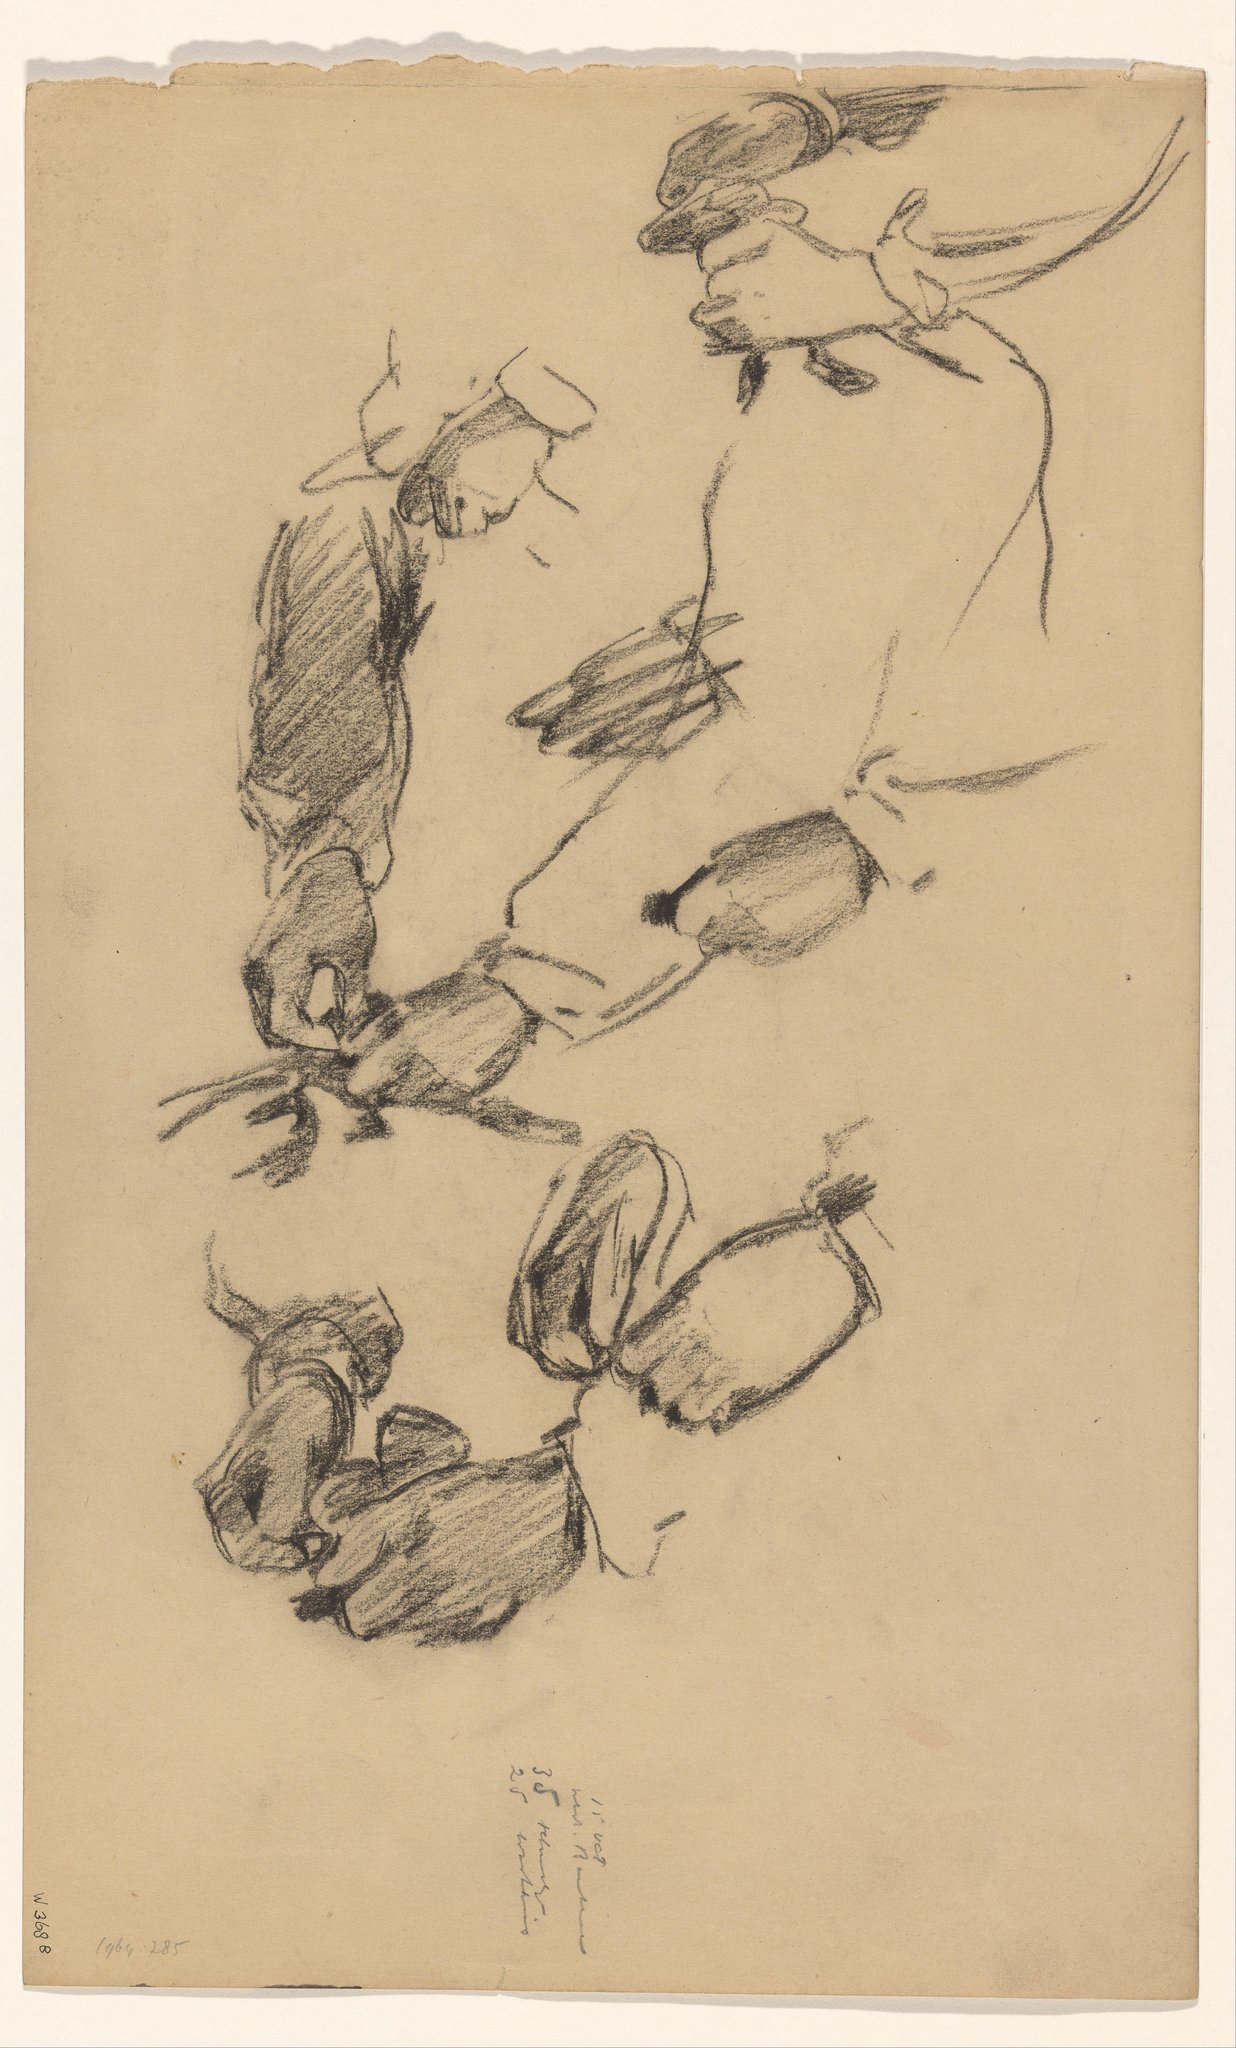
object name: sketchbook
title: Schetsboek met 24 bladen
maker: willem witsen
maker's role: draughtsman, painter, print maker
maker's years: 1860-1923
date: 1892-1897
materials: cardboard, chalk, linen, paper, pencil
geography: ede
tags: playing with snow and ice - cc - adult(s) ~ snow and ice, farmers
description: Schetsboek bestaande uit 24 bladen met figuurstudies en landschappen.